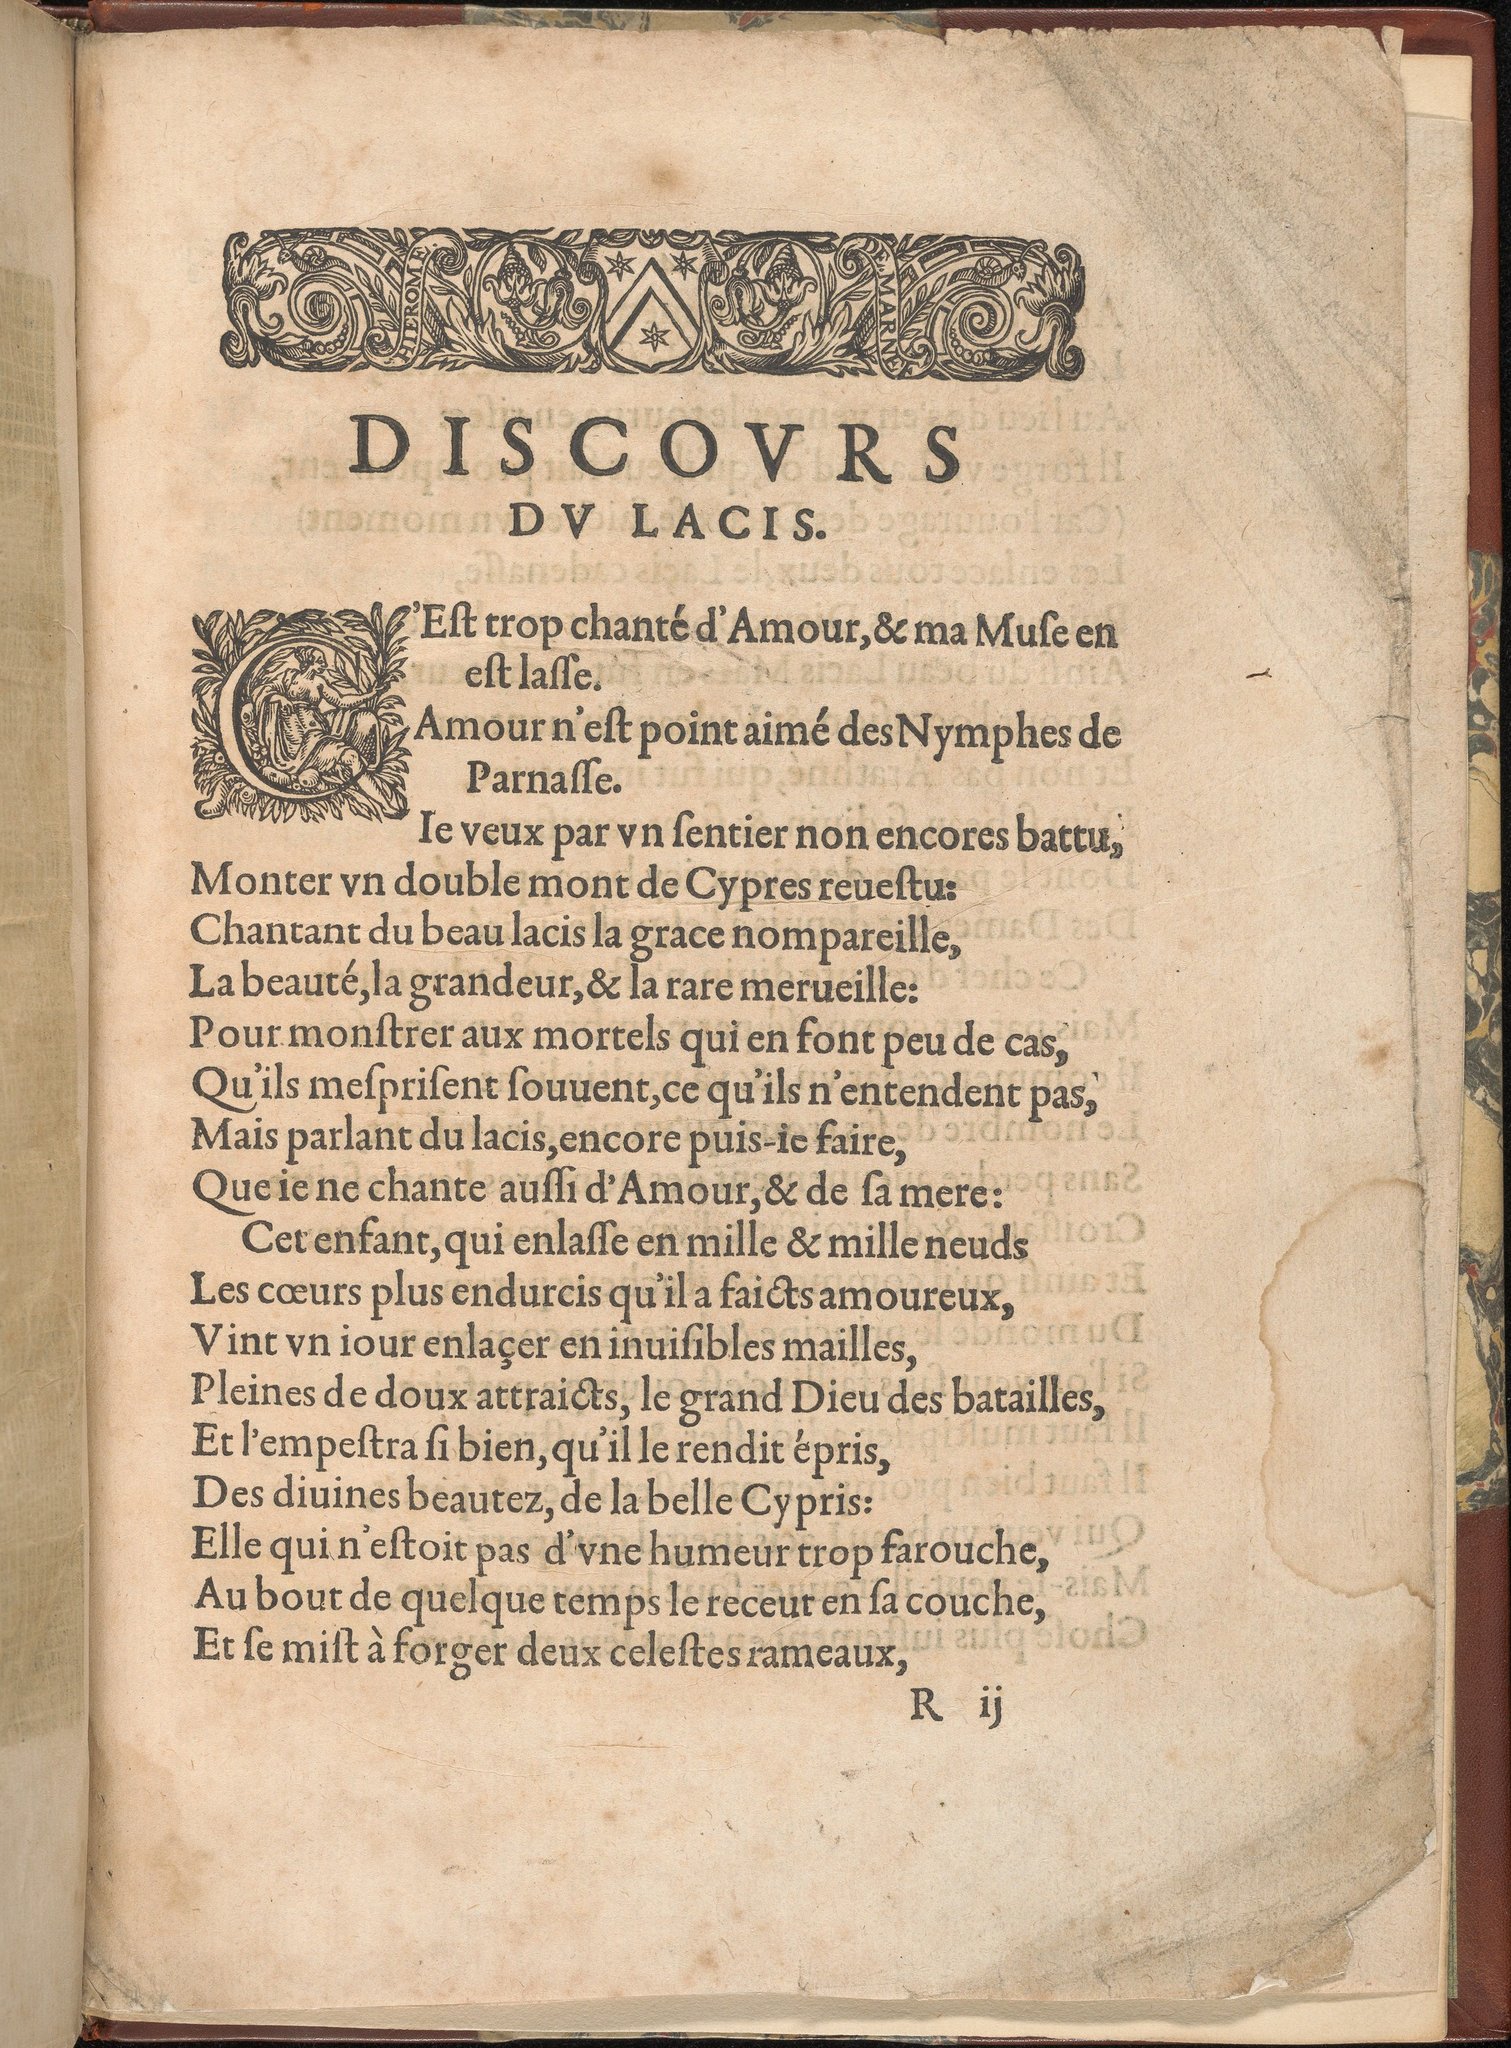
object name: book print ornament architecture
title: Les Secondes Oeuvres, et Subtiles Inventions De Lingerie du Seigneur Federic de Vinciolo Venitien, page 66 (recto)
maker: federico de vinciolo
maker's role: designer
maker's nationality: italian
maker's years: 1582-1599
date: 1603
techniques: woodcut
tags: flowers,vines,coat of arms